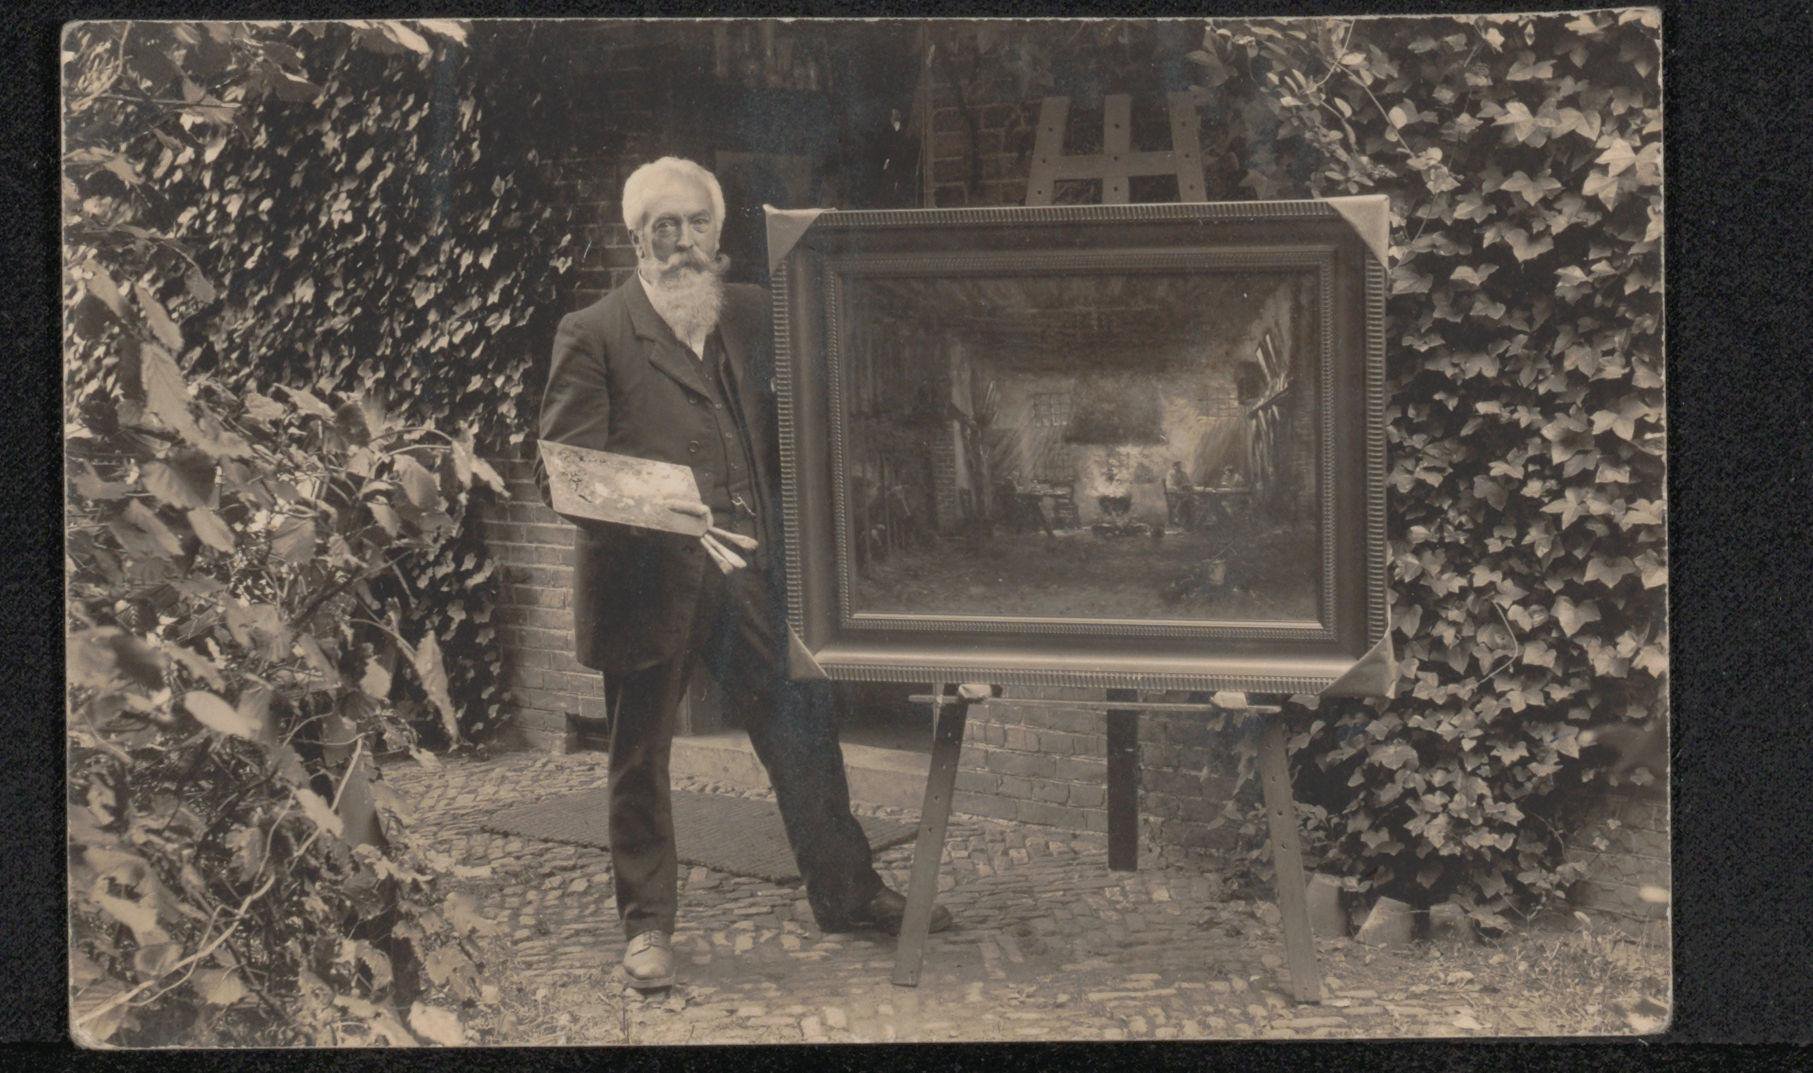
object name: ansichtkaart, prentbriefkaart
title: Prentbriefkaart met Willem van der Worp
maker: Anonymous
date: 1813-1878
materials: cardboard, pencil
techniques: gelatin silver print, writing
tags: print maker, draughtsman, willem van der worp, painting (including book-illumination, miniature-painting), historical persons (portraits and scenes from the life)